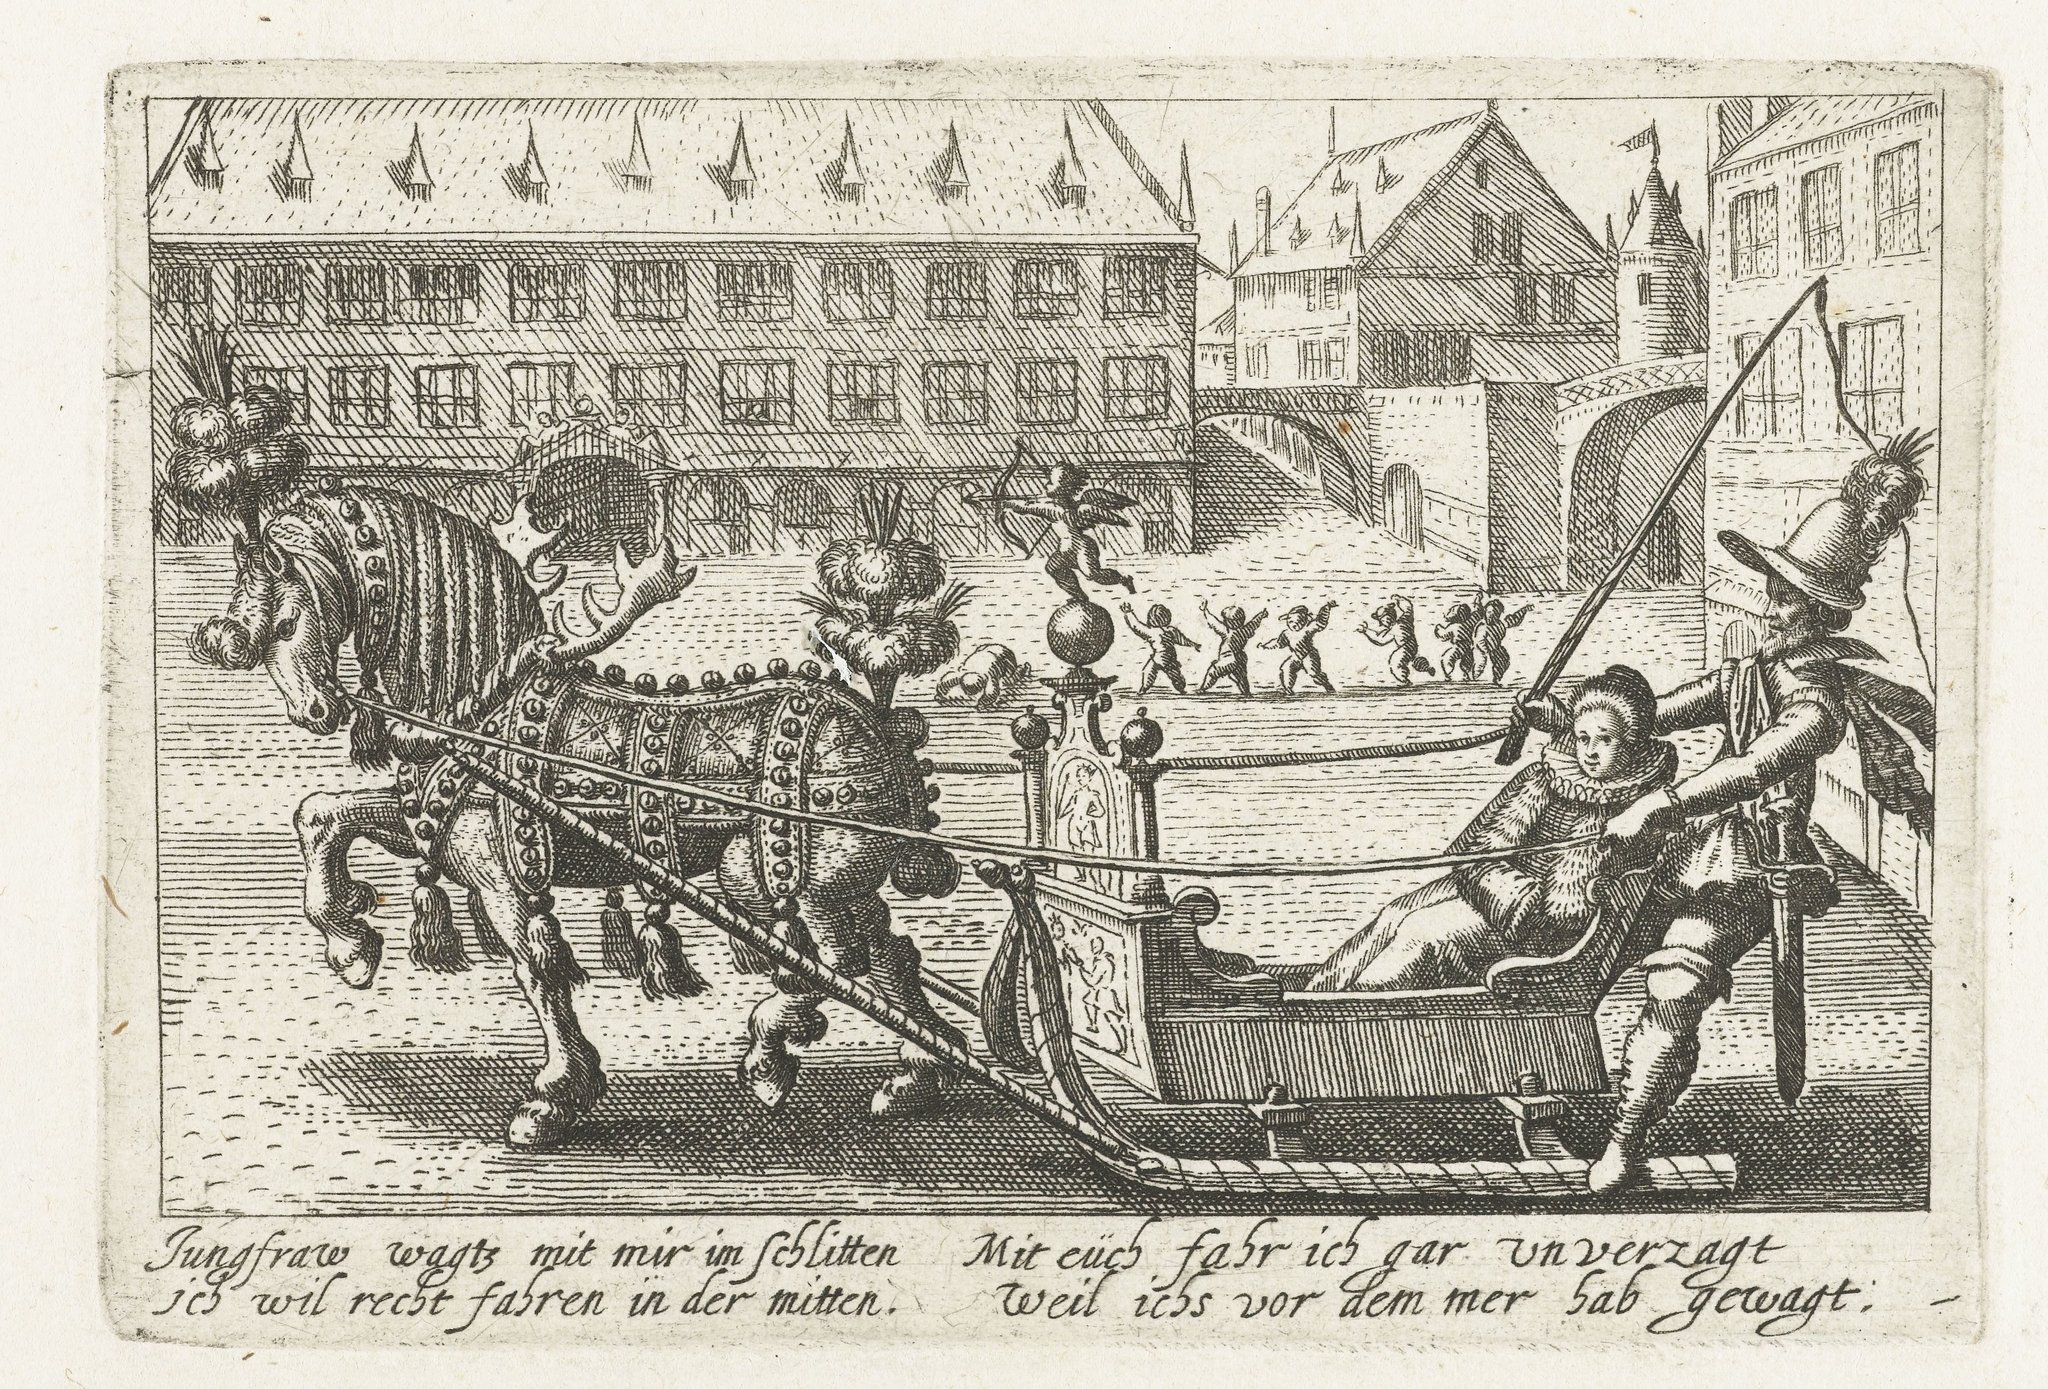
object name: print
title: Pugillus facetiarum iconographicarum in studiosorum (...)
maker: jacob van der heyden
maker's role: draughtsman, print maker, publisher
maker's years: 1573-1645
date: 1608-1618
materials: paper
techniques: engraving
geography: straatsburg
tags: 'album amicorum', 'stammbuch', city-view in general; 'veduta', morality, sledge, sleigh (winter sports)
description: Deze serie, getiteld ‘Pugillus facetiarum iconographicarum in studiosorum (…)’, bestond vermoedelijk uit 36 of meer prenten. Van deze serie zijn in ieder geval twee uitgaven bekend, uit 1608 en 1618. De prenten uit deze serie in de collectie van het Rijksmuseum (RP-P-1996-1 t/m RP-P-1996-36) zijn vermoedelijk afkomstig uit verschillende uitgaven, of uit de tweede uitgave. De inhoud van beide uitgaven verschilt, maar om de precieze inhoud van de verschillende uitgaven vast te stellen is meer onderzoek nodig. Er zijn geen volledige exemplaren van de eerste uitgave bekend. Aan de hand van de analyse van een andere serie, ‘Jeucht spieghel’,* die kopieën van ‘Pugillus’ bevat en is uitgegeven in 1610 én de aanwezige exemplaren van prenten uit ‘Pugillus’ in een inmiddels verloren album amicorum uit 1610,** kan in ieder geval van een aantal prenten gesteld worden dat ze al voorkwamen in de uitgave van 1608. Dit geldt voor RP-P-1996-1 (de titelprent), RP-P-1996-5, RP-P-1996-6, RP-P-1996-7, RP-P-1996-8, RP-P-1996-9, RP-P-1996-10, RP-P-1996-11, RP-P-1996-12, RP-P-1996-13, RP-P-1996-14, RP-P-1996-15, RP-P-1996-16, RP-P-1996-17, RP-P-1996-18, RP-P-1996-19, RP-P-1996-24, RP-P-1996-28, RP-P-1996-29, RP-P-1996-33 en RP-P-1996-35. Van één prent (RP-P-1996-31) kan vastgesteld worden dat die pas in de latere uitgave van 1618 voorkwam, omdat het kopie is van een prent uit weer een andere serie, ‘Academia sive speculum vitae scholasticae (…)’, die werd uitgegeven in 1612.*** Van de huidige prent is onduidelijk of hij al voorkwam in de uitgave van 1608. * Z.G.H.P.H.S [Zacharias Heyns]. Jeucht spieghel. S.l.s.n., 1610. Voor een gedigitaliseerd exemplaar zie: https://archive.org/details/ned-kbn-all-00000628-001/page/n9/mode/2up. ** Zie: Erman, Wilhelm en Ewald Horn. Bibliographie der deutschen Universitäten, systematisch geordnetes Verzeichnis der bis Ende 1899 gedruckten Bücher und Aufsätze über das deutsche Universitätswesen. Leipzig en Berlijn: Verlag von B.G. Teubner, 1904, dl. 1, p. 826-832, no. 17328. https://archive.org/details/bibliographieder01ermauoft/page/826/mode/2up *** Passe, Crispijn van de (I). Academia sive speculum vitae scholasticae (…). Arnhem: Johannes Janssonius [Jan Jansz.], 1612. Voor een gedigitaliseerd exemplaar zie: http://gallica.bnf.fr/ark:/12148/btv1b55005974h.